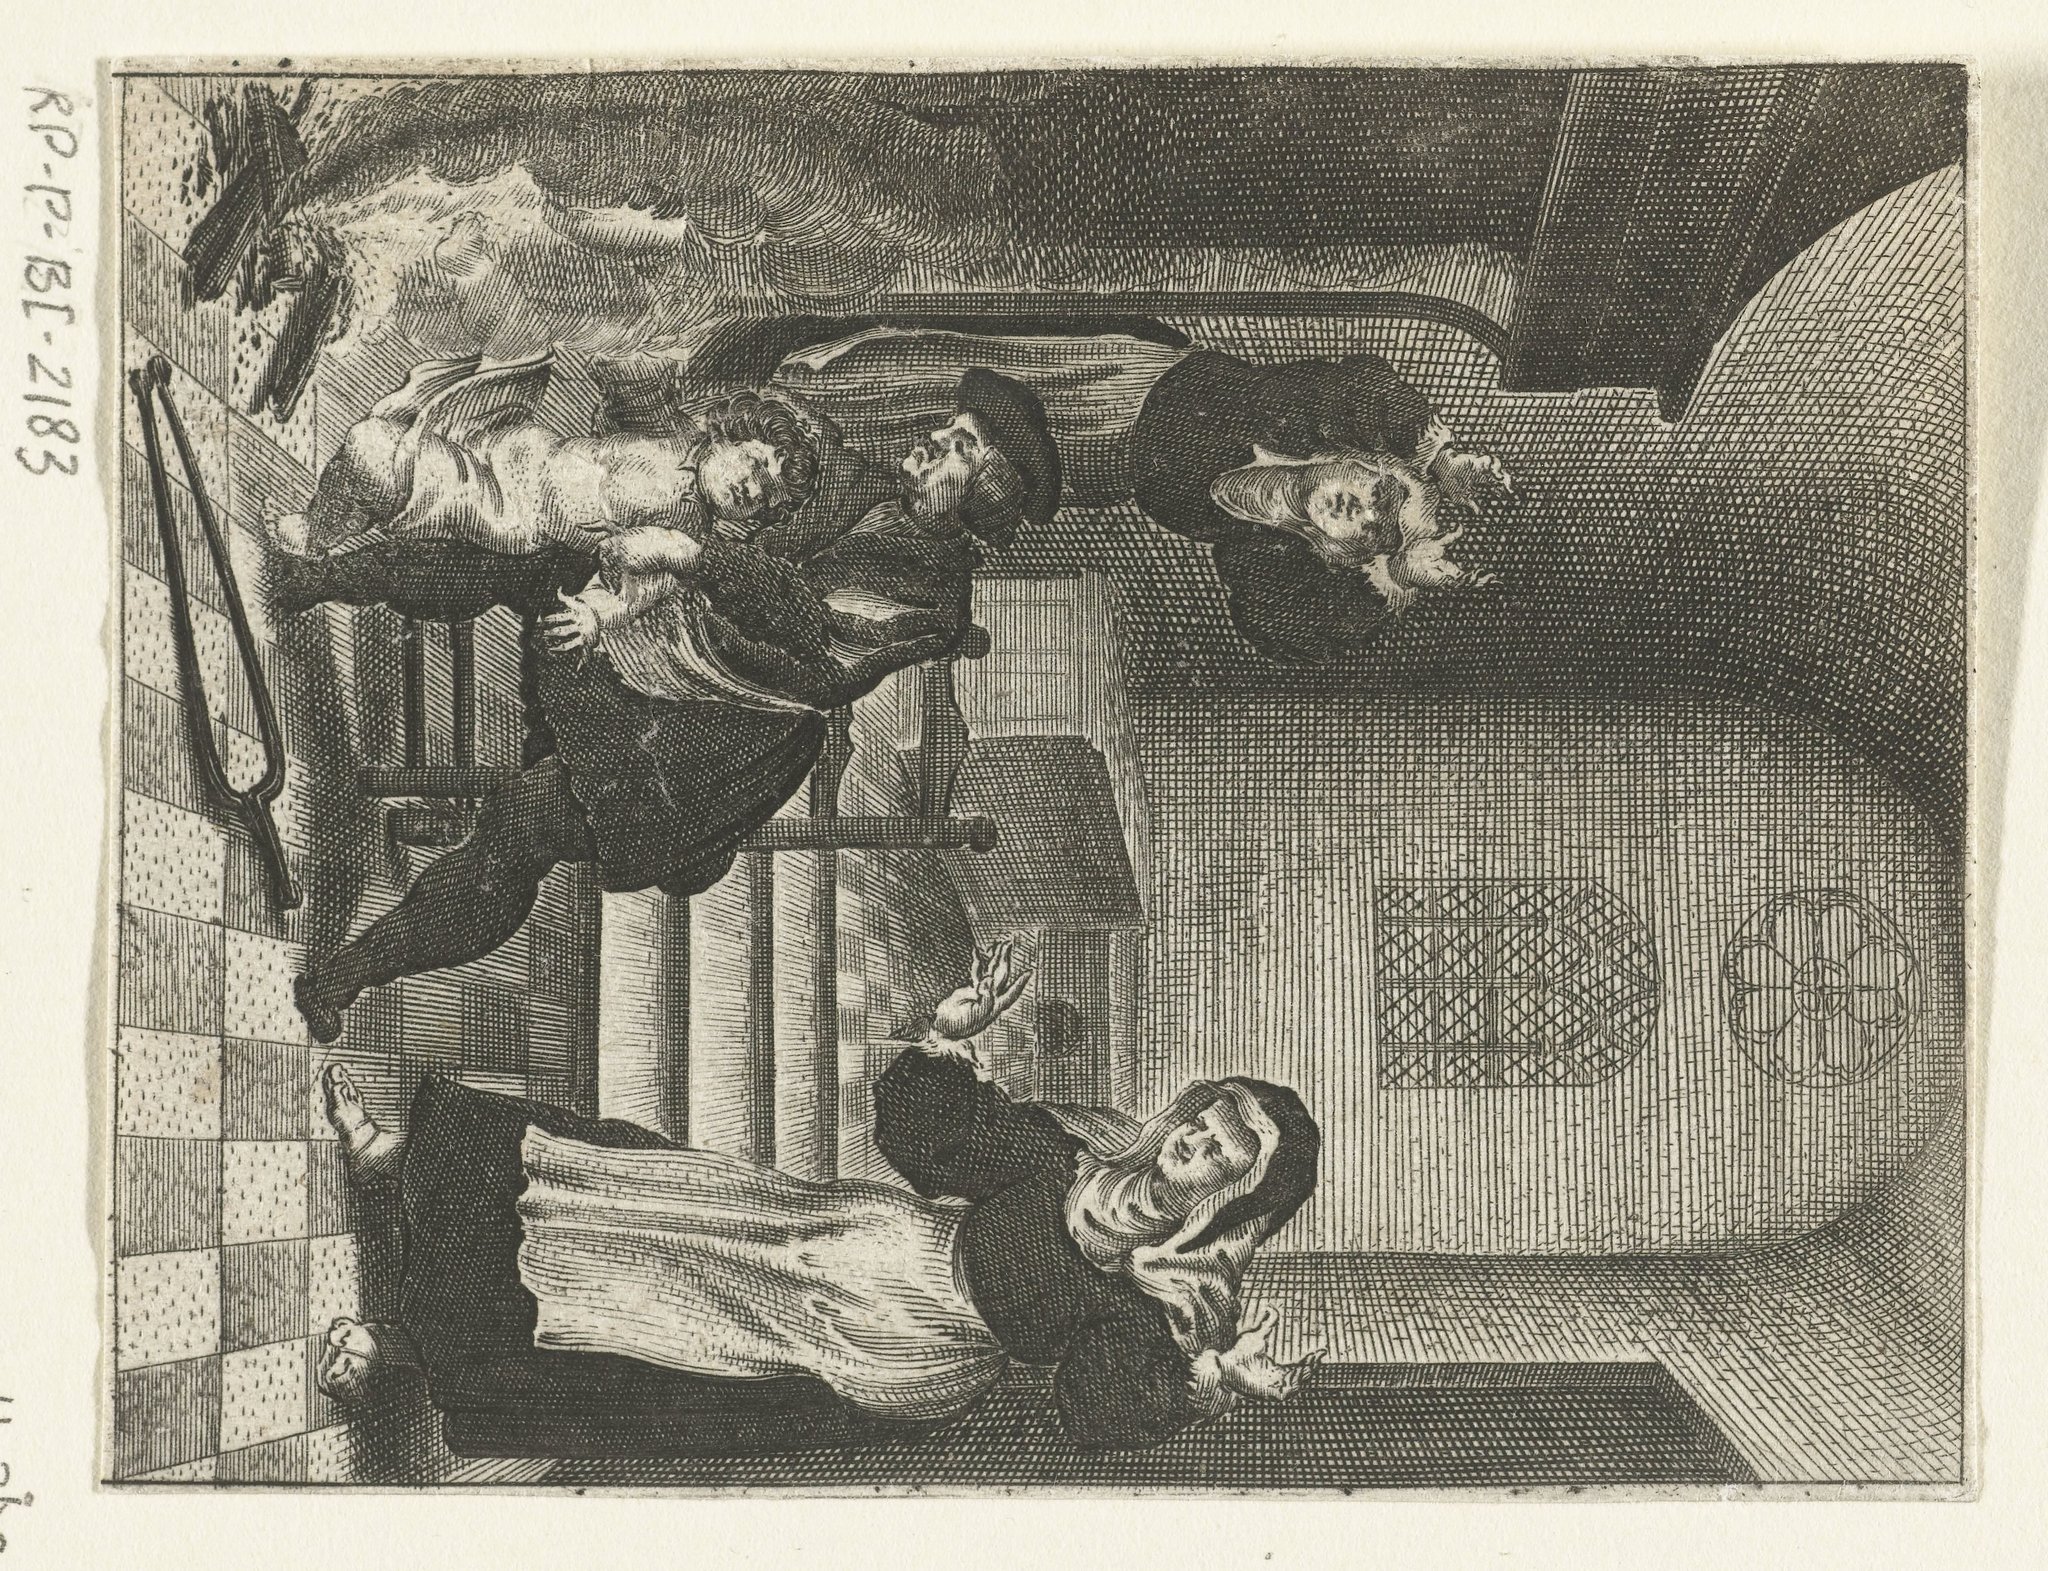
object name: book illustration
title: Kind valt van zijn vaders schoot in het vuur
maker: Anonymous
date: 1639-1689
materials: paper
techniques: engraving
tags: on fire, ablaze, legends and miracles associated with the eucharist (or the host)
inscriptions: collector's mark: Lugt 240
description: Kopie naar prent van Boëtius Adamsz. Bolswert. Bolswert op zijn beurt baseerde zich op een ontwerp van Jacob Cornelisz. van Oostsanen.